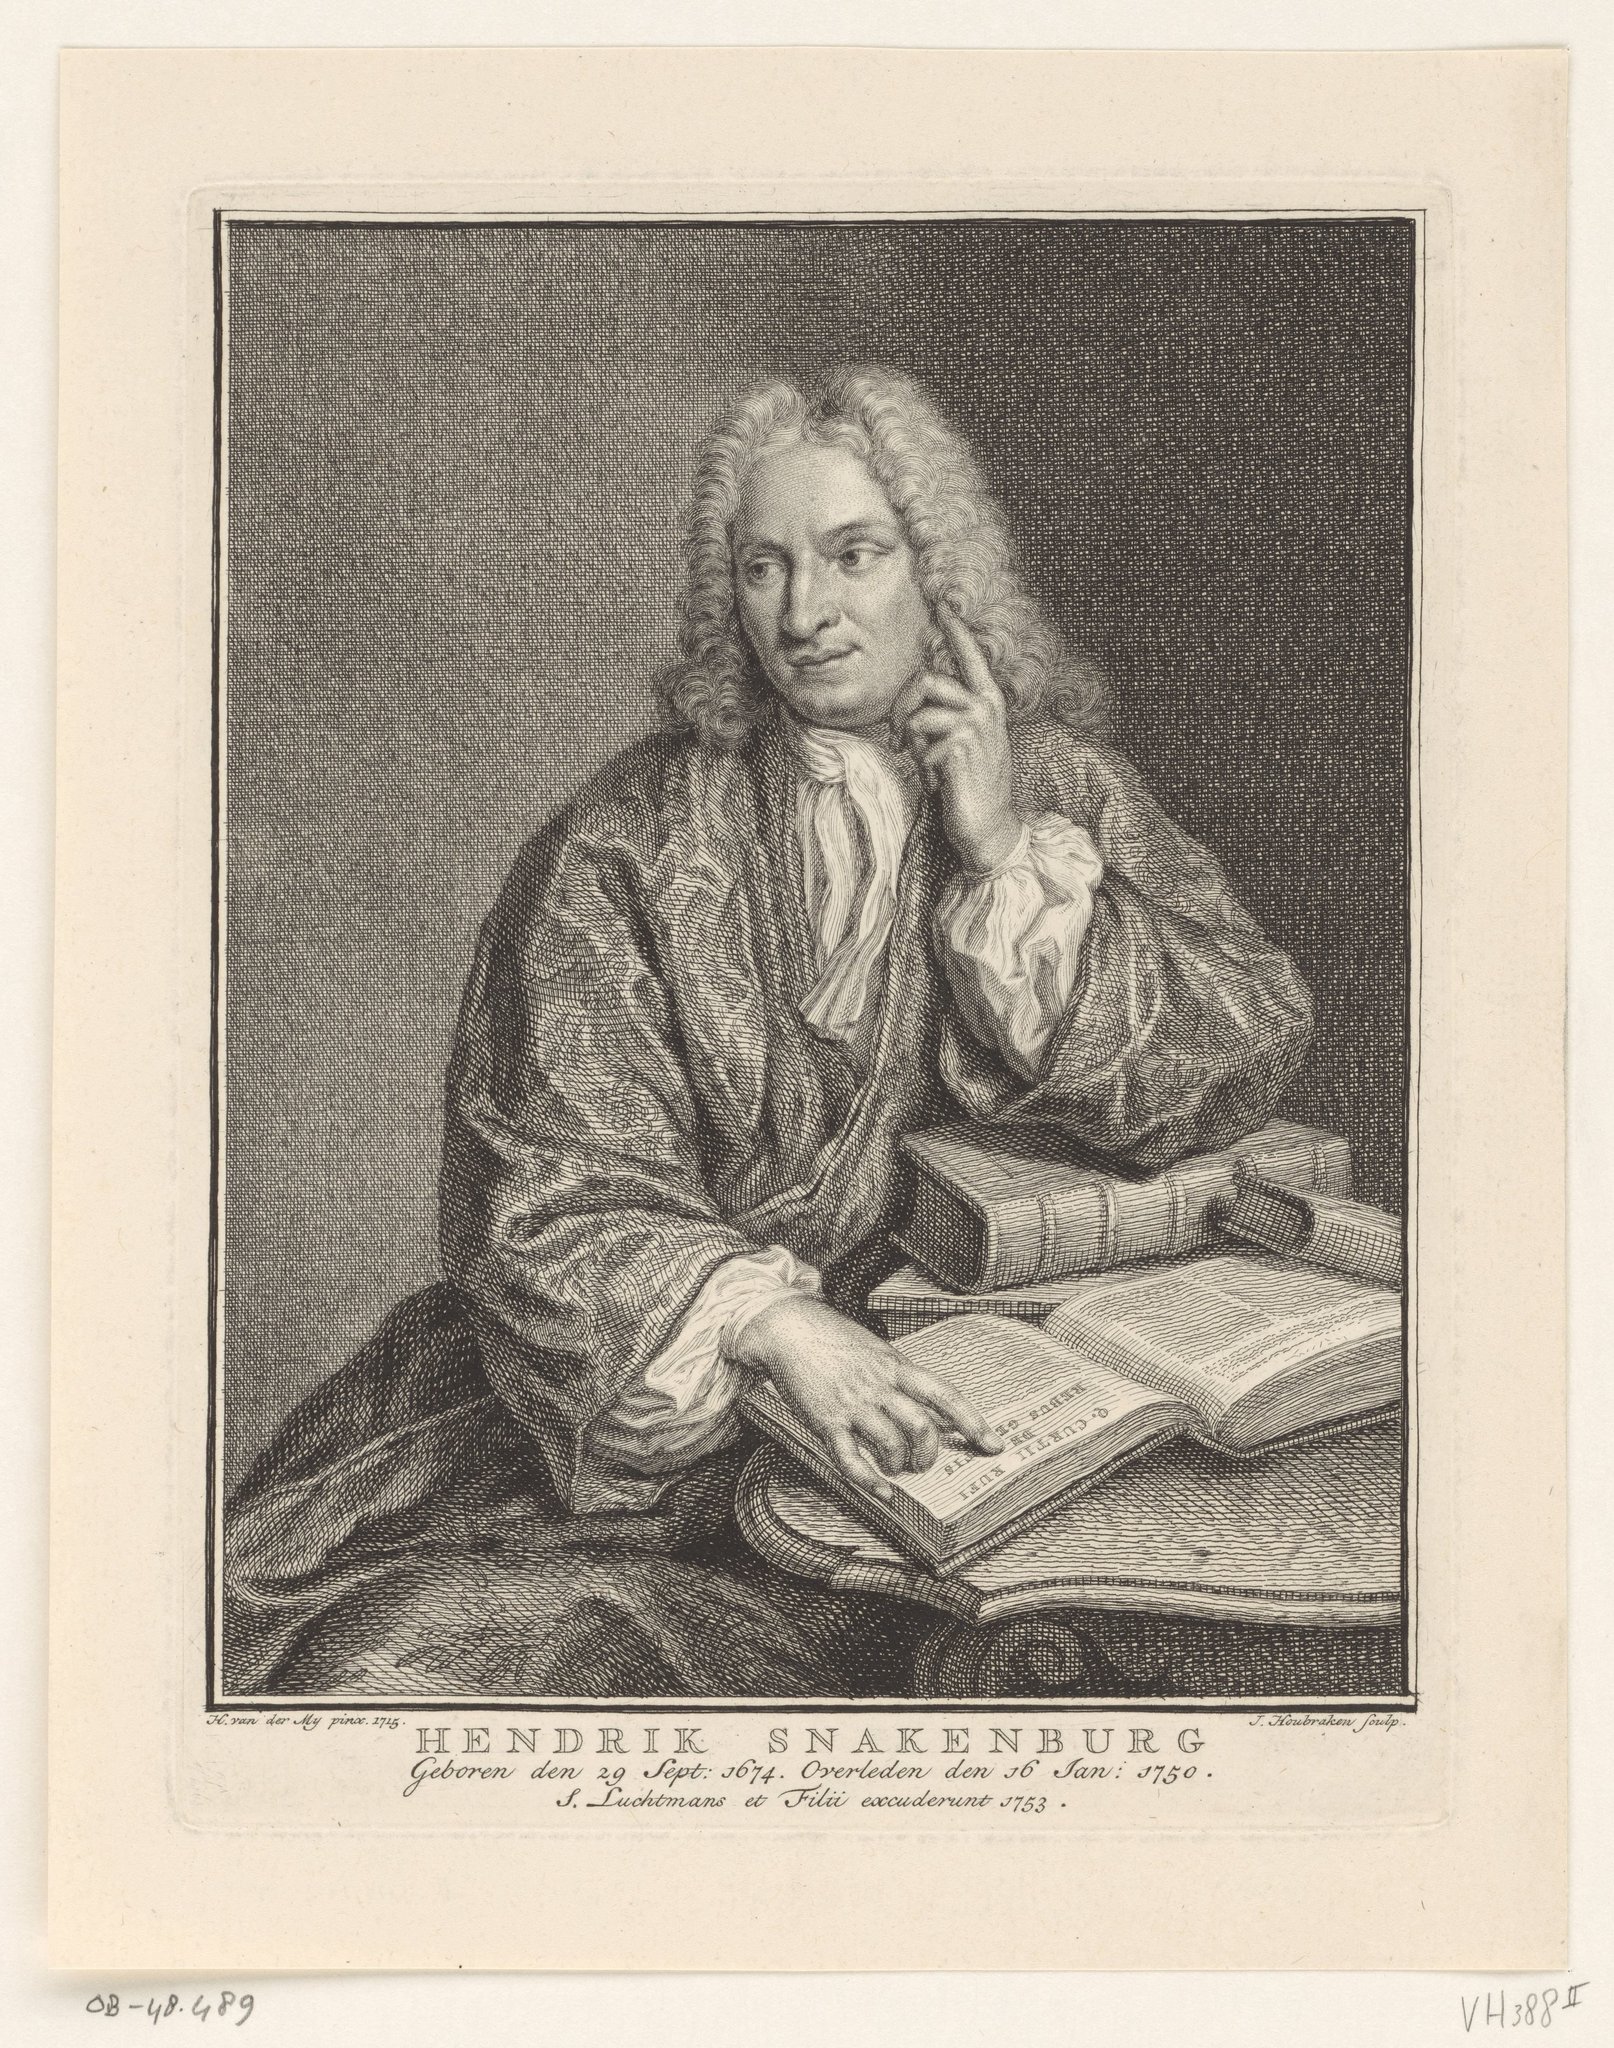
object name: print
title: Portret van Hendrik Snakenburg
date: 1753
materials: paper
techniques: engraving, etching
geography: amsterdam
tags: hendrik snakenburg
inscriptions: collector's mark: Lugt 240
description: Portret van Hendrik Snakenburg, zittend aan een tafel met daarop enkele boeken. Onder het portret zijn naam en gegevens in twee regels in het Nederlands.